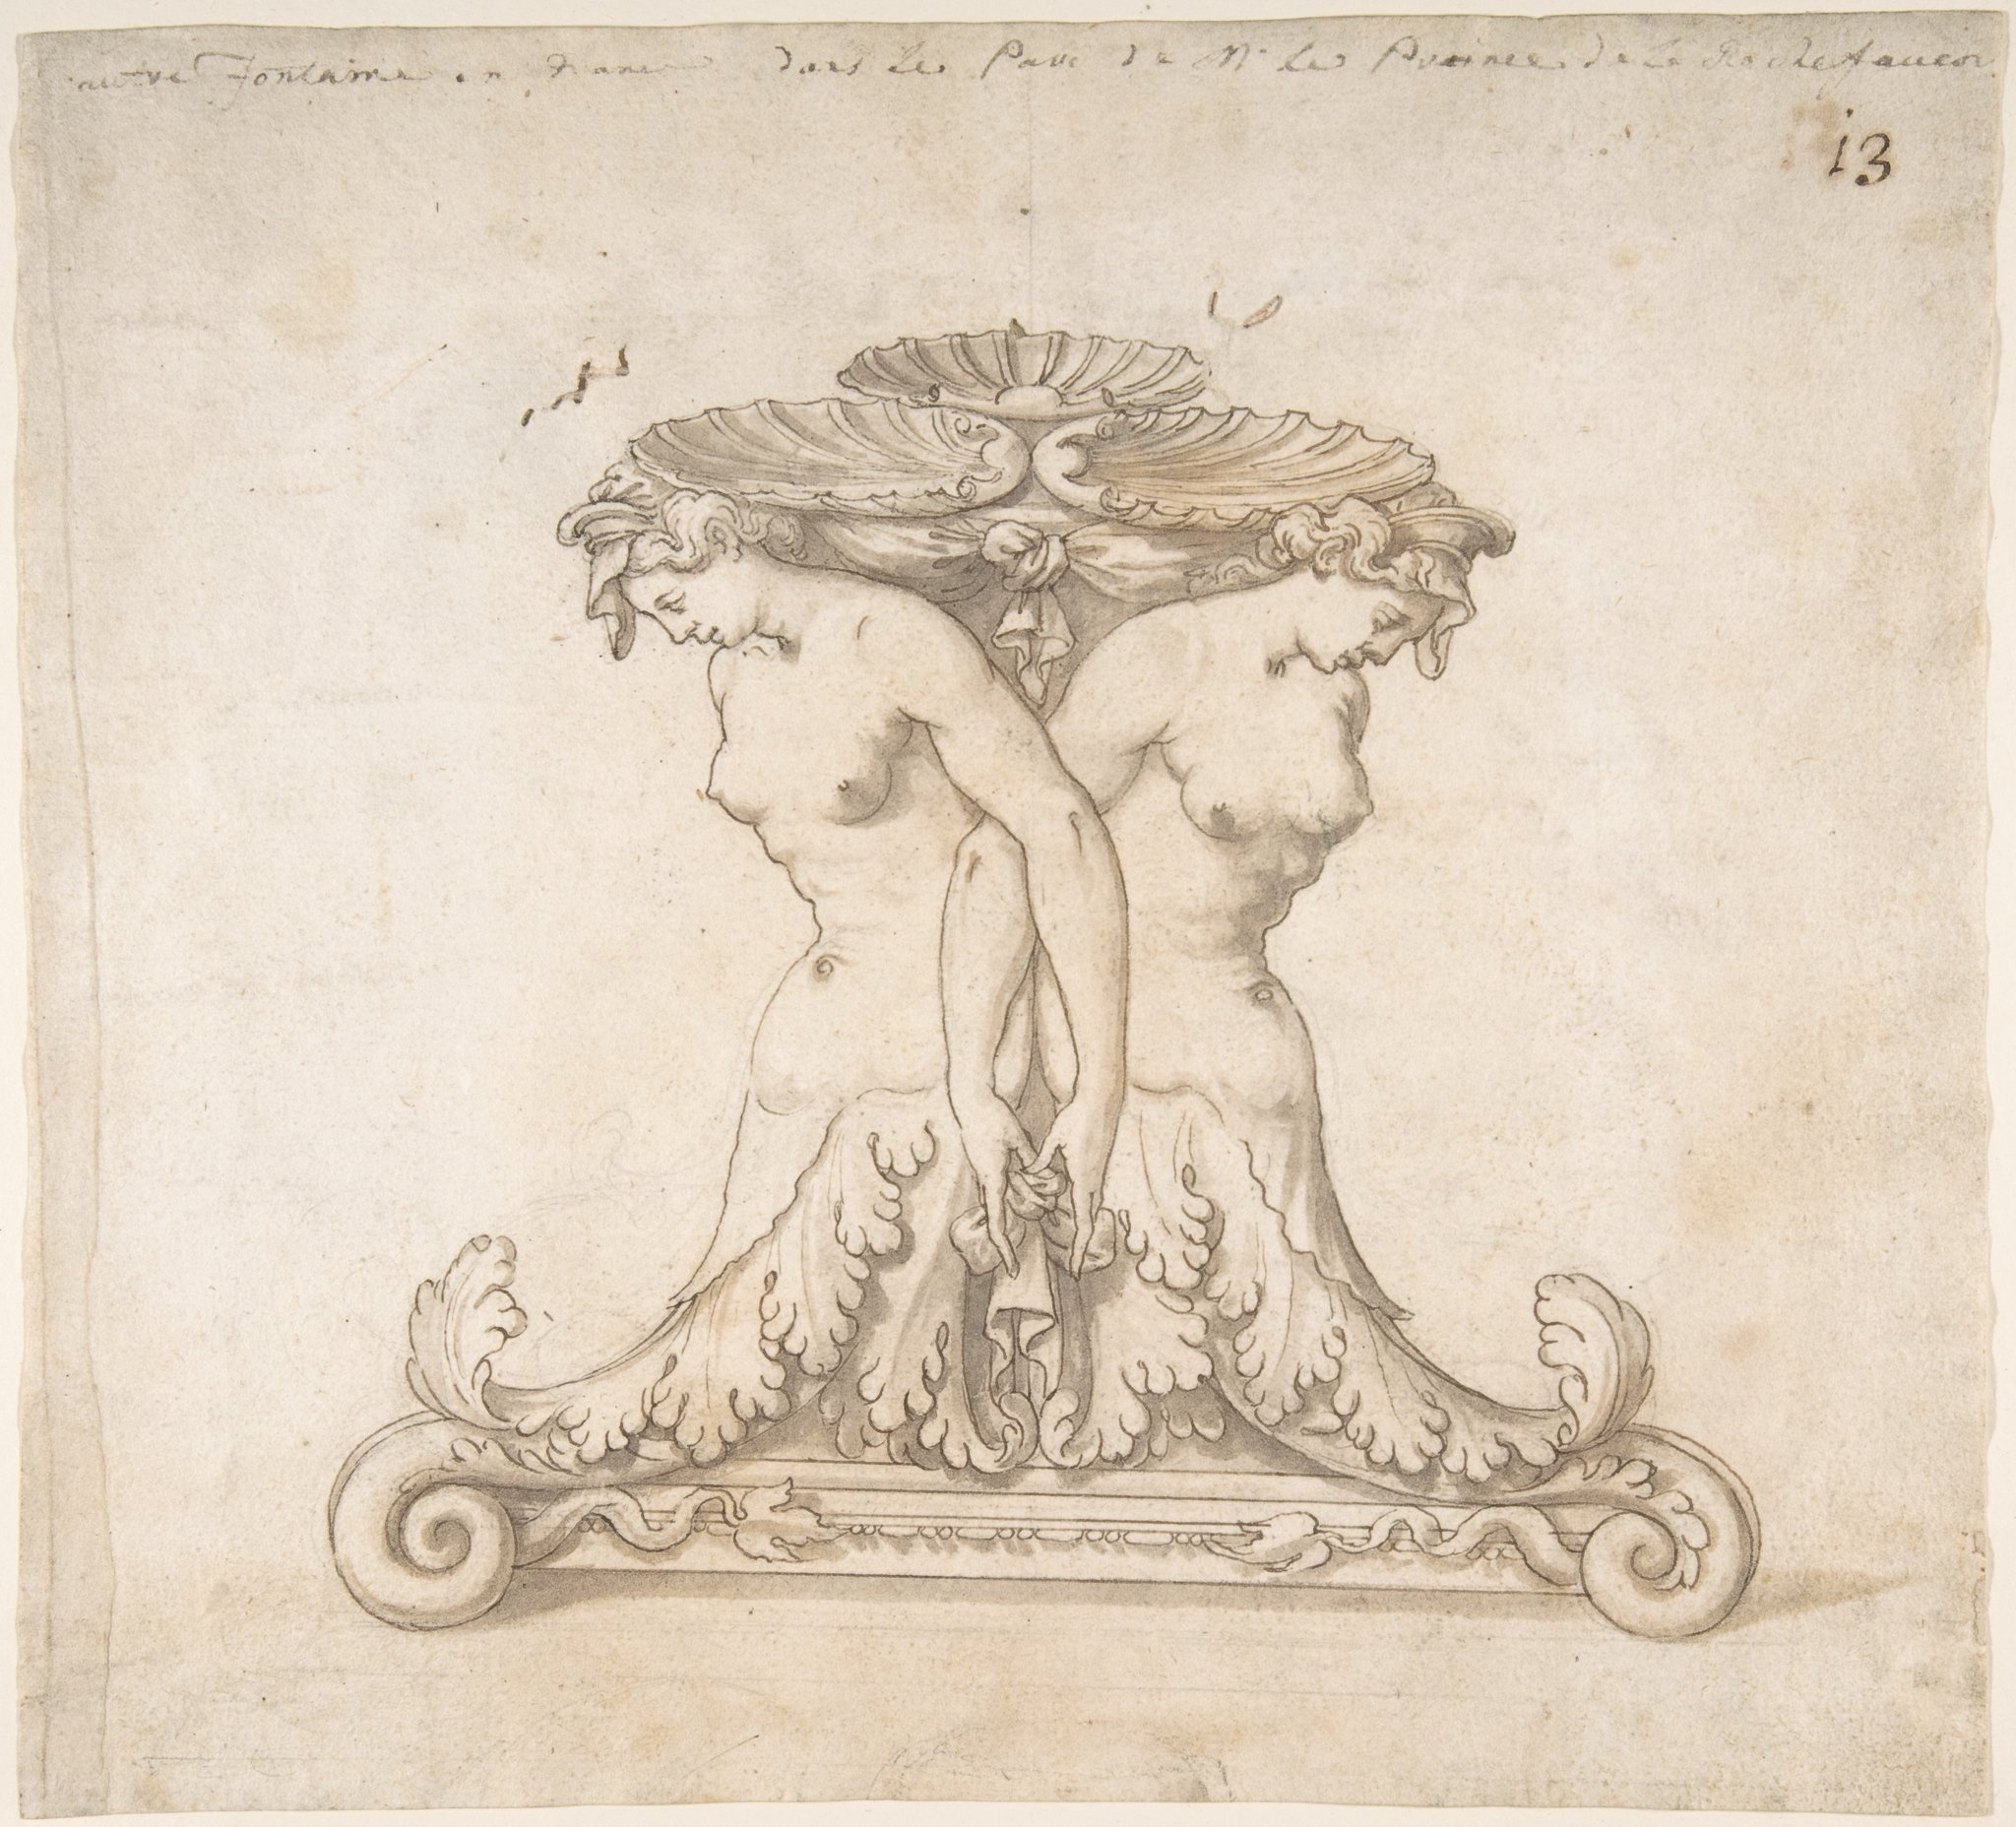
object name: drawing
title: Drawing of a Fountain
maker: anonymous, french, 16th century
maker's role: artist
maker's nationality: french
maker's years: 1500-1600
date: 1501-1600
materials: chalk, ink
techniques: brush, pen, wash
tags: fountains,female nudes